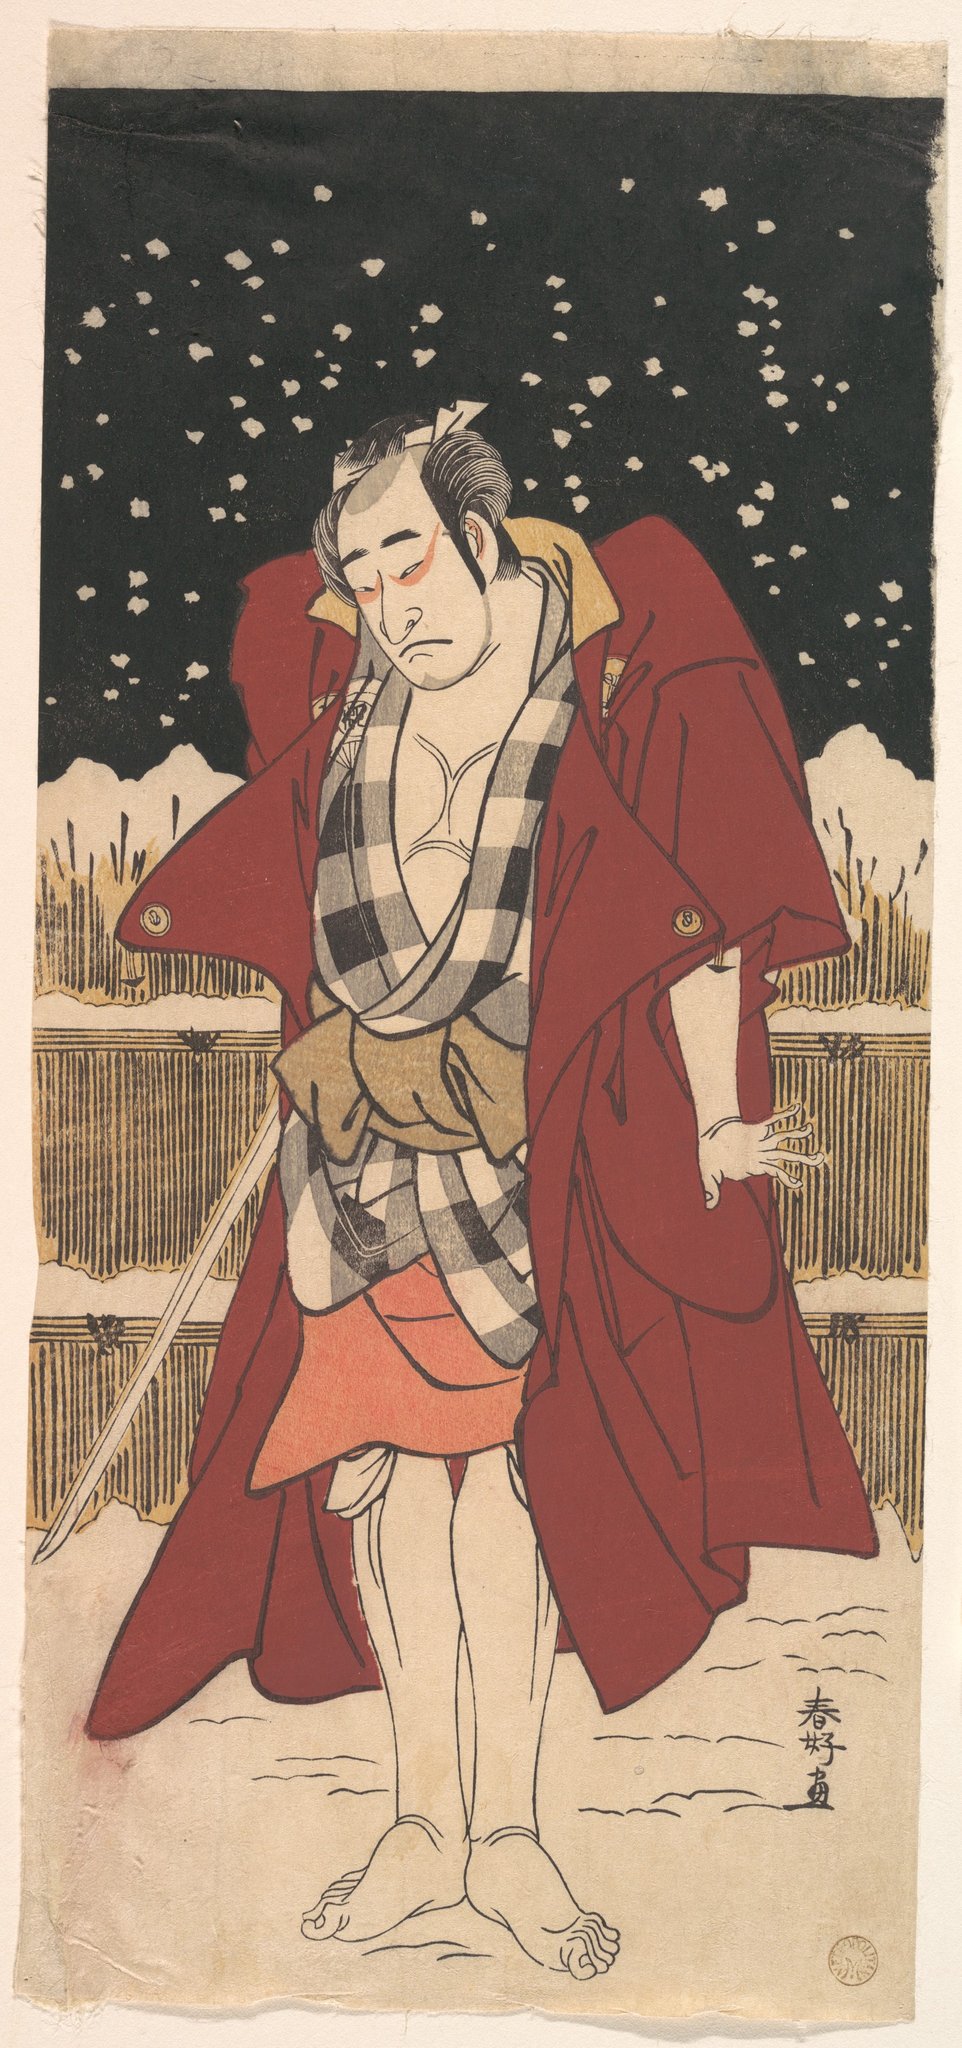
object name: print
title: Onoe Matsusuke as Man Armed with a Sword, Standing in Snow before a Fence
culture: japanese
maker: katsukawa shunkō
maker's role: artist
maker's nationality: japanese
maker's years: 1743-1812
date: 1786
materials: ink, paper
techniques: woodblock print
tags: swords,men,snow,actors